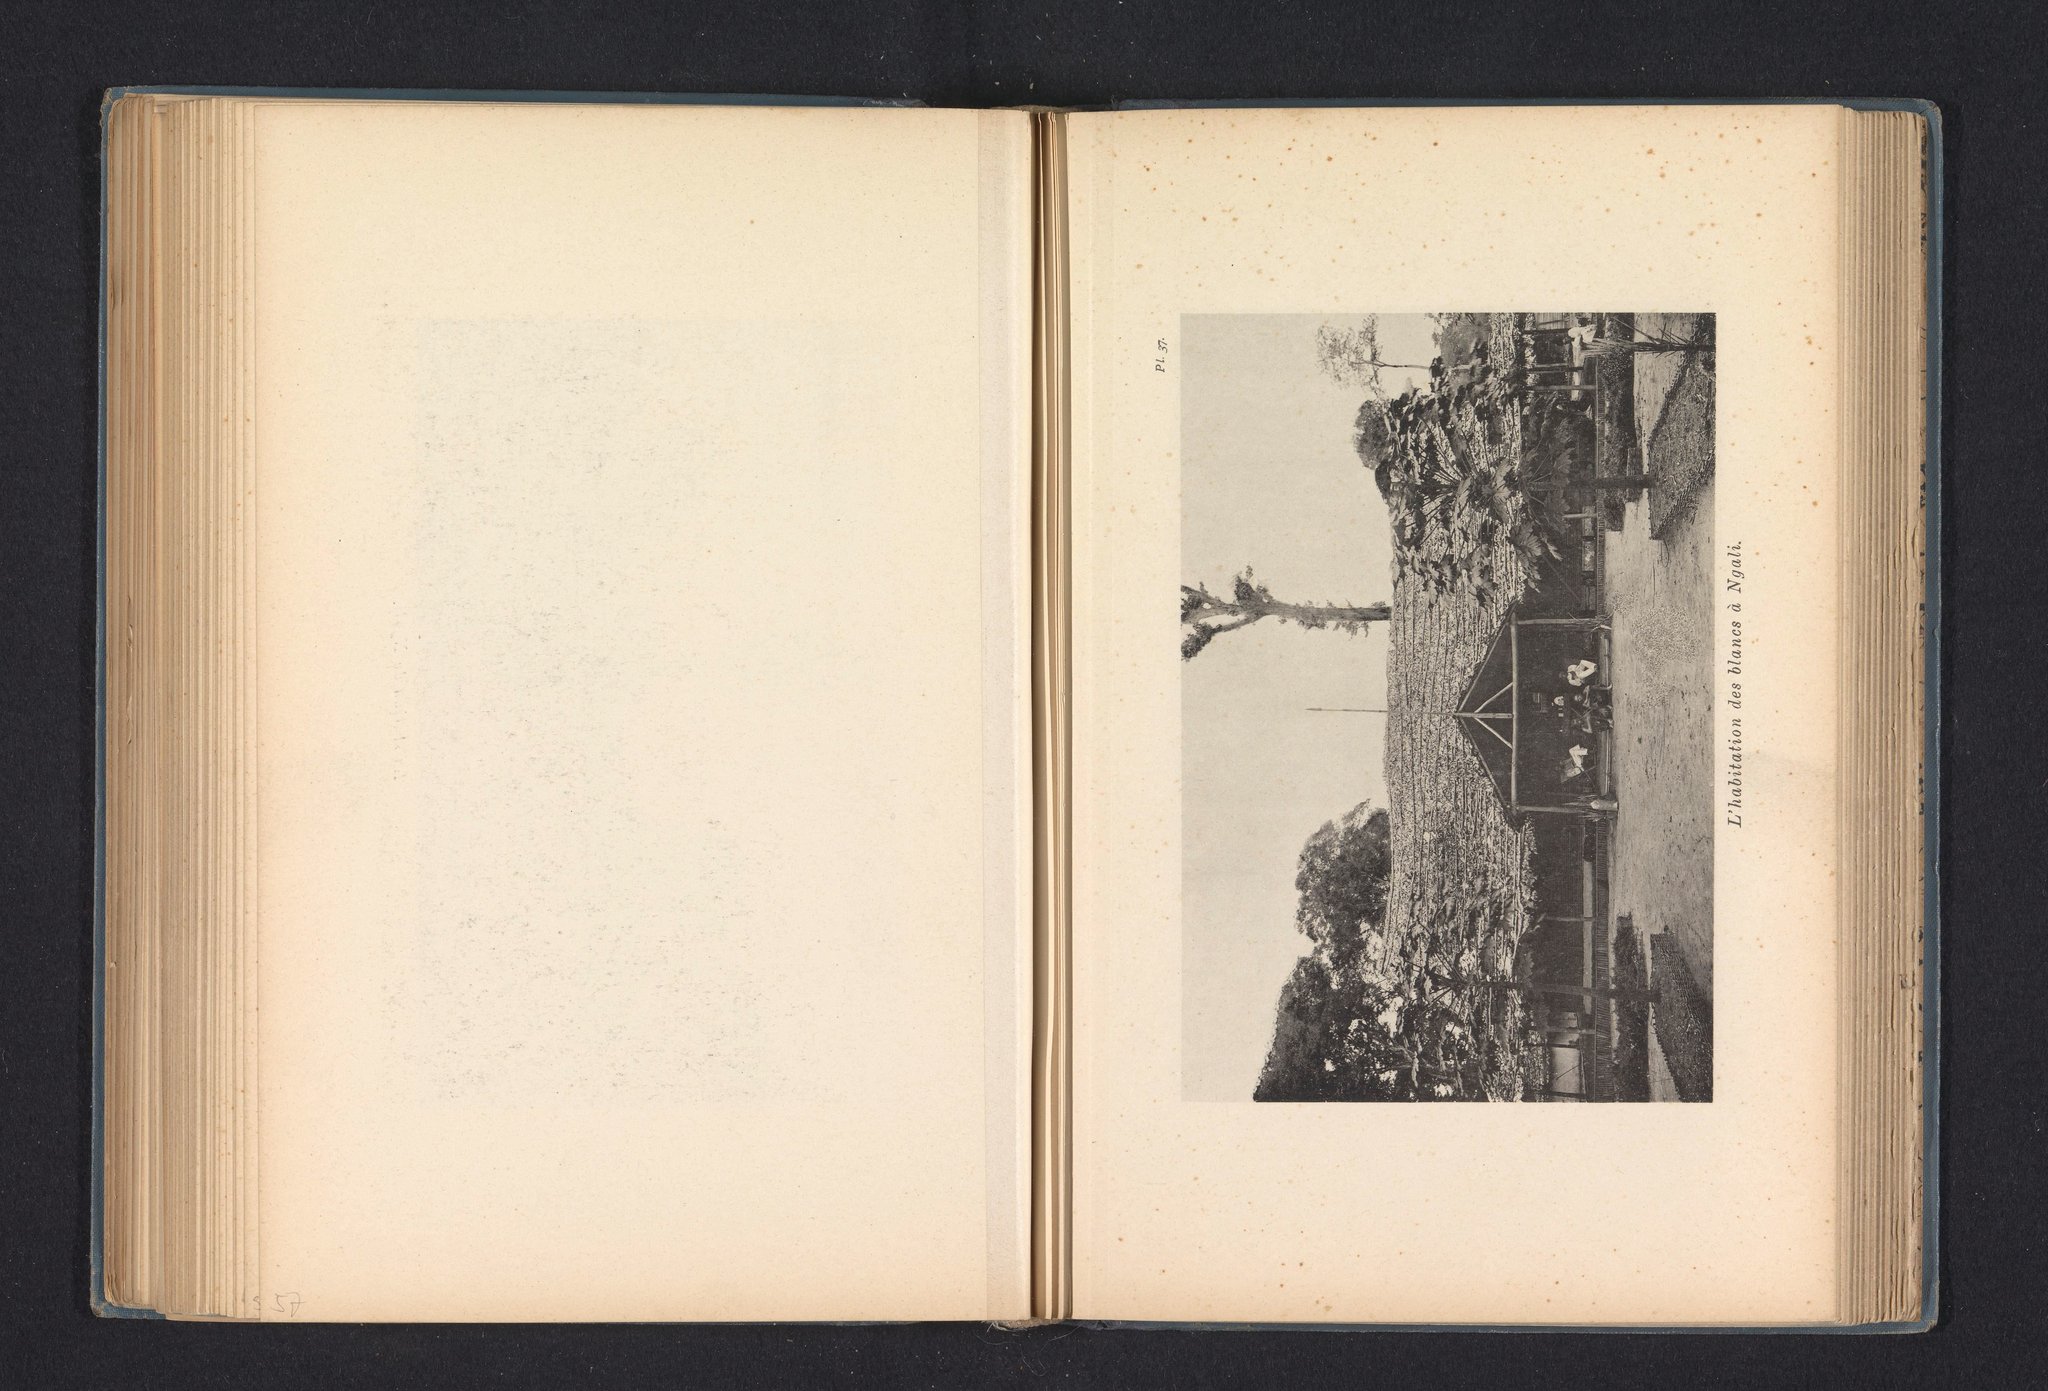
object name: photomechanical print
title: Exterieur van een woning te Ngali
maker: franz thonner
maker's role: botanicus, ontdekkingsreiziger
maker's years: 1863-1928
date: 1896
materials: paper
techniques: photograph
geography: ngali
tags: housing, façade (of house or building)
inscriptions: number: ‘Pl. 37.’